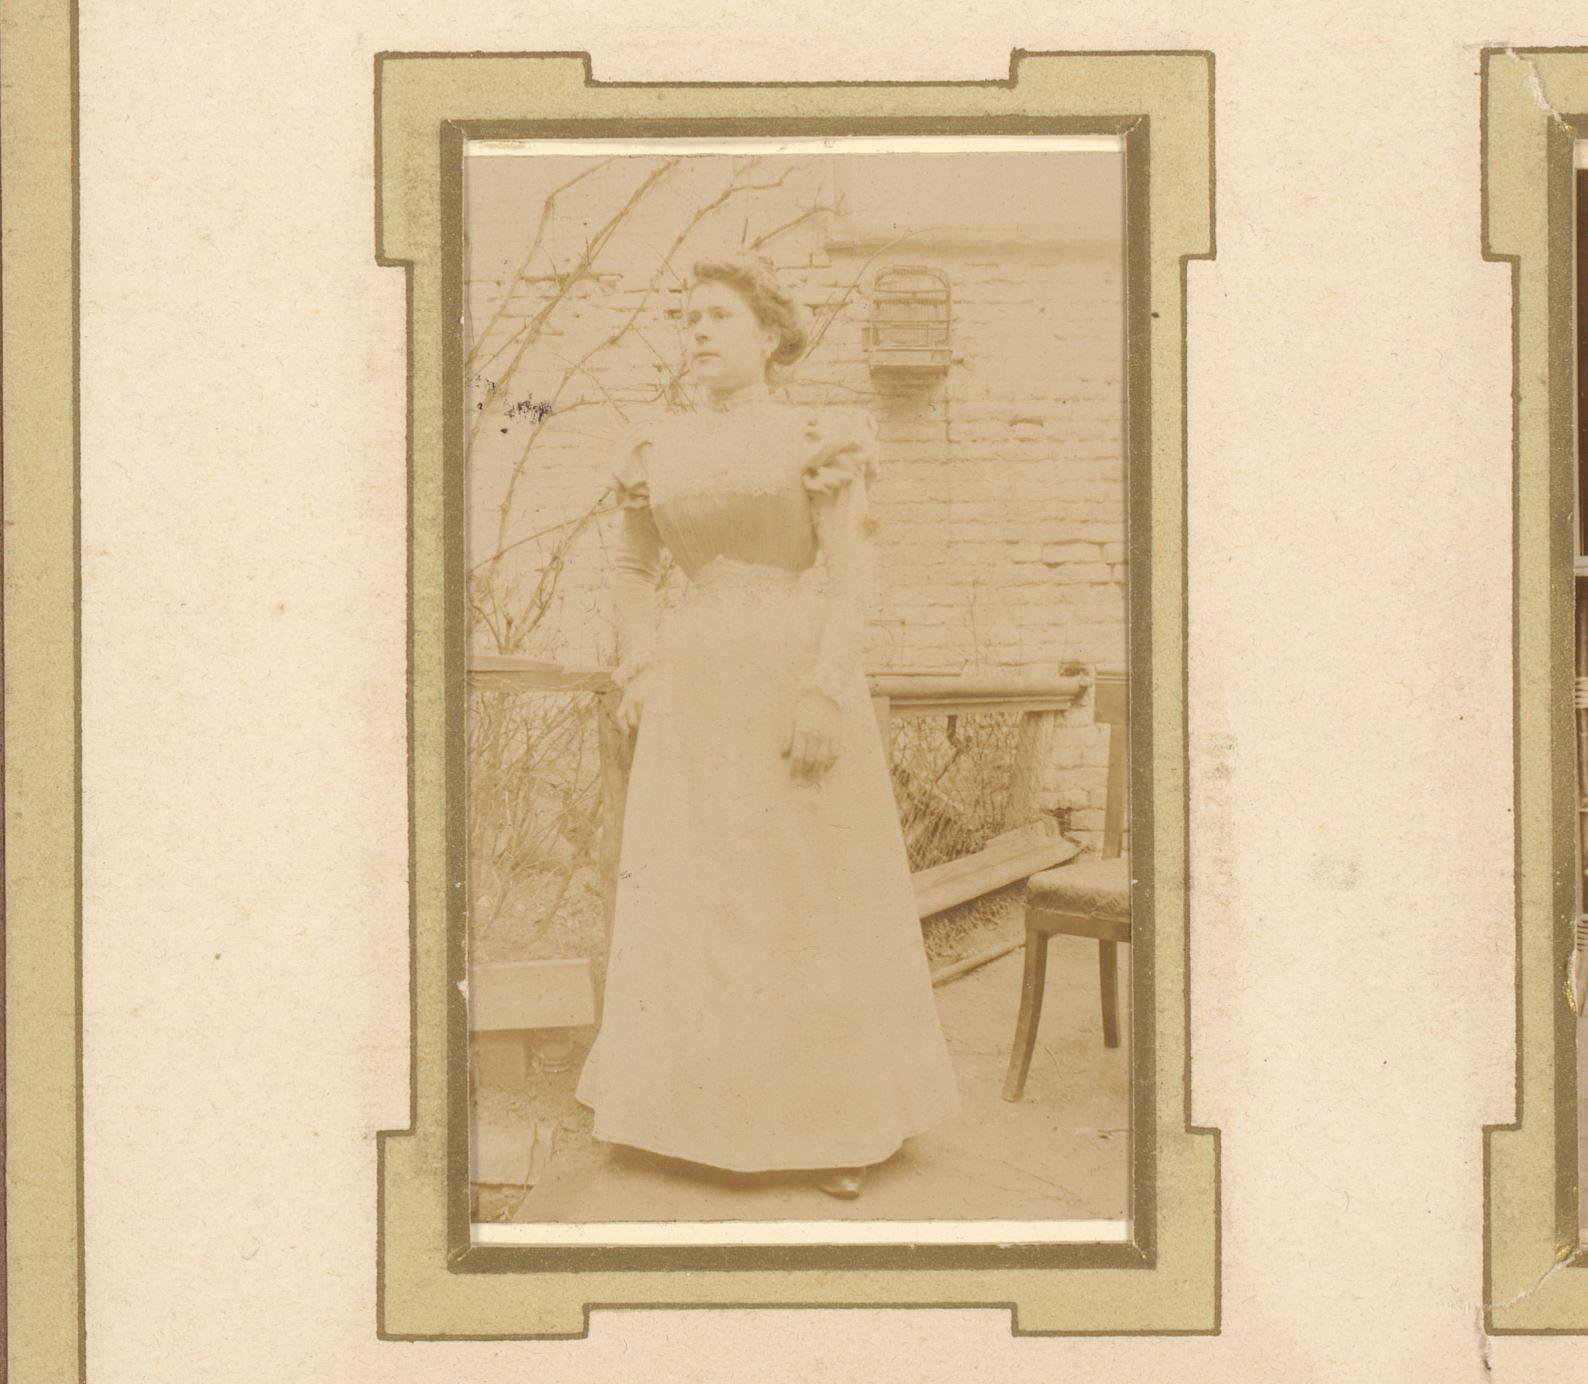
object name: carte de visite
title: Portret van een jonge vrouw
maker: Anonymous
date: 1860-1900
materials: cardboard, photographic support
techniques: albumen print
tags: adolescent, young woman, maiden, historical persons - bb - woman